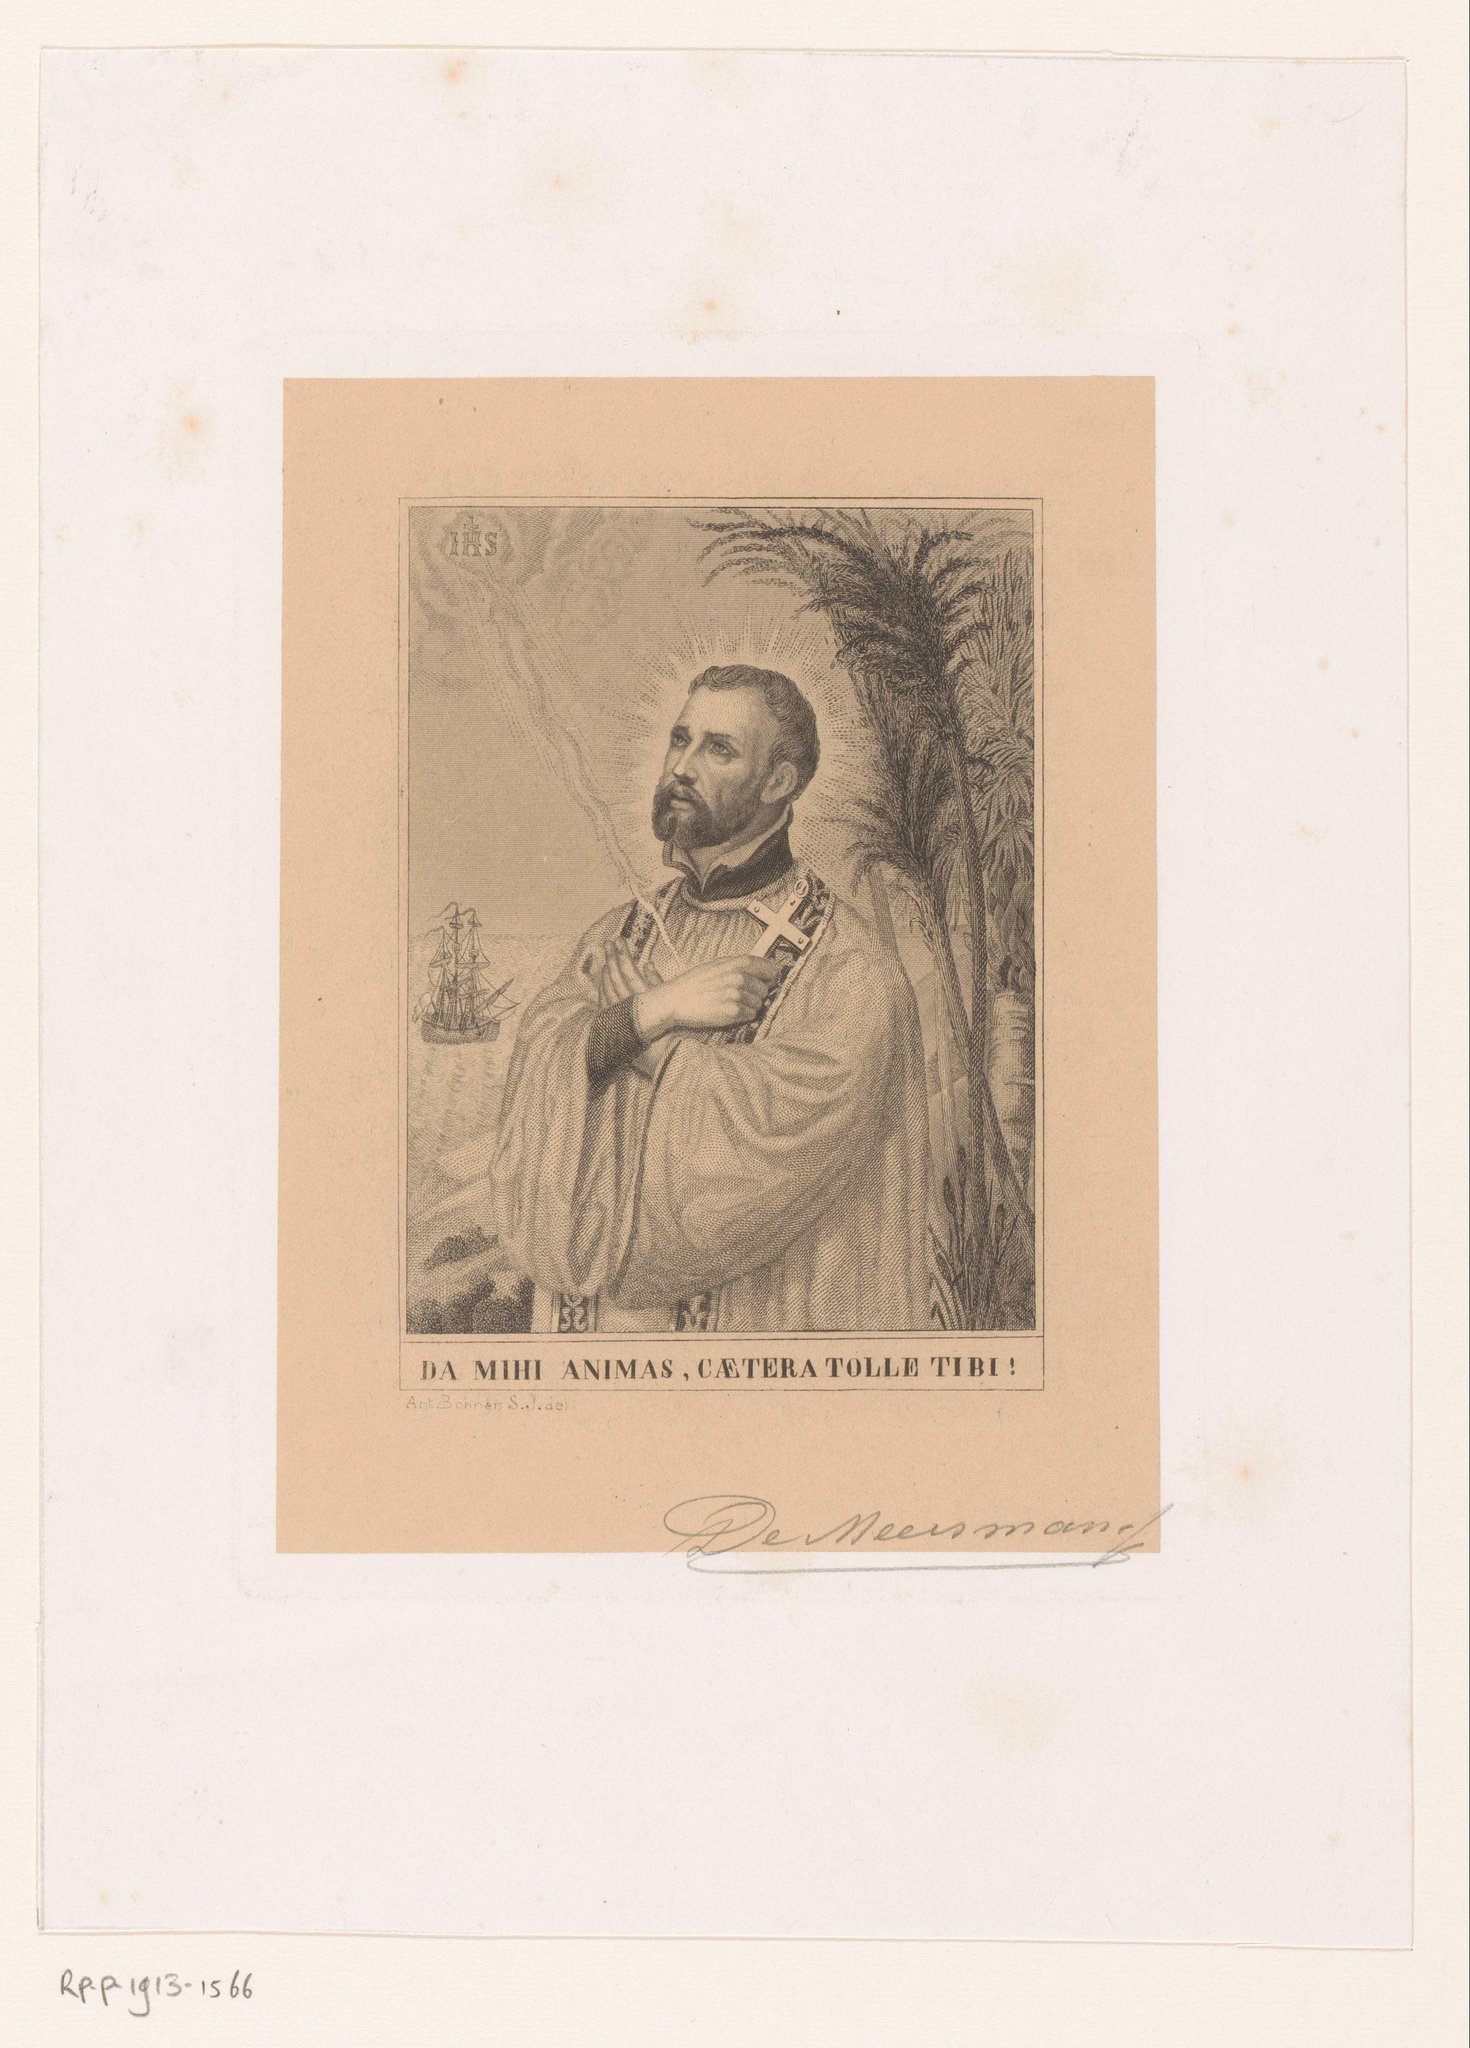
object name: print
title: Portret van Francis Xavier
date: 1840-1905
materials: paper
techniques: etching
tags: sailing-ship, sailing-boat, historical persons, the jesuit missionary francis xavier; possible attributes: cross, crucifix, flaming heart, indian, lily, torch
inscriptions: collector's mark: Lugt 2228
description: Francis Xavier ging als missionaris van de Jezuïeten naar Indië om daar het geloof te verspreiden.